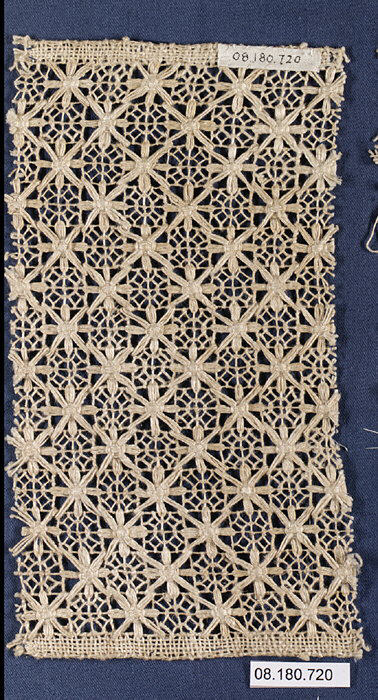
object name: insertion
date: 1801-1900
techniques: embroidery